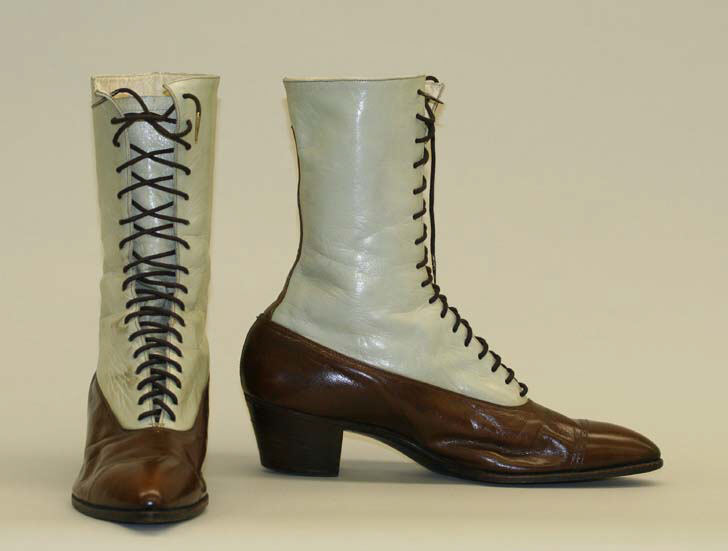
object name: shoe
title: Shoes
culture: american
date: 1900-1910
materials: cotton, leather